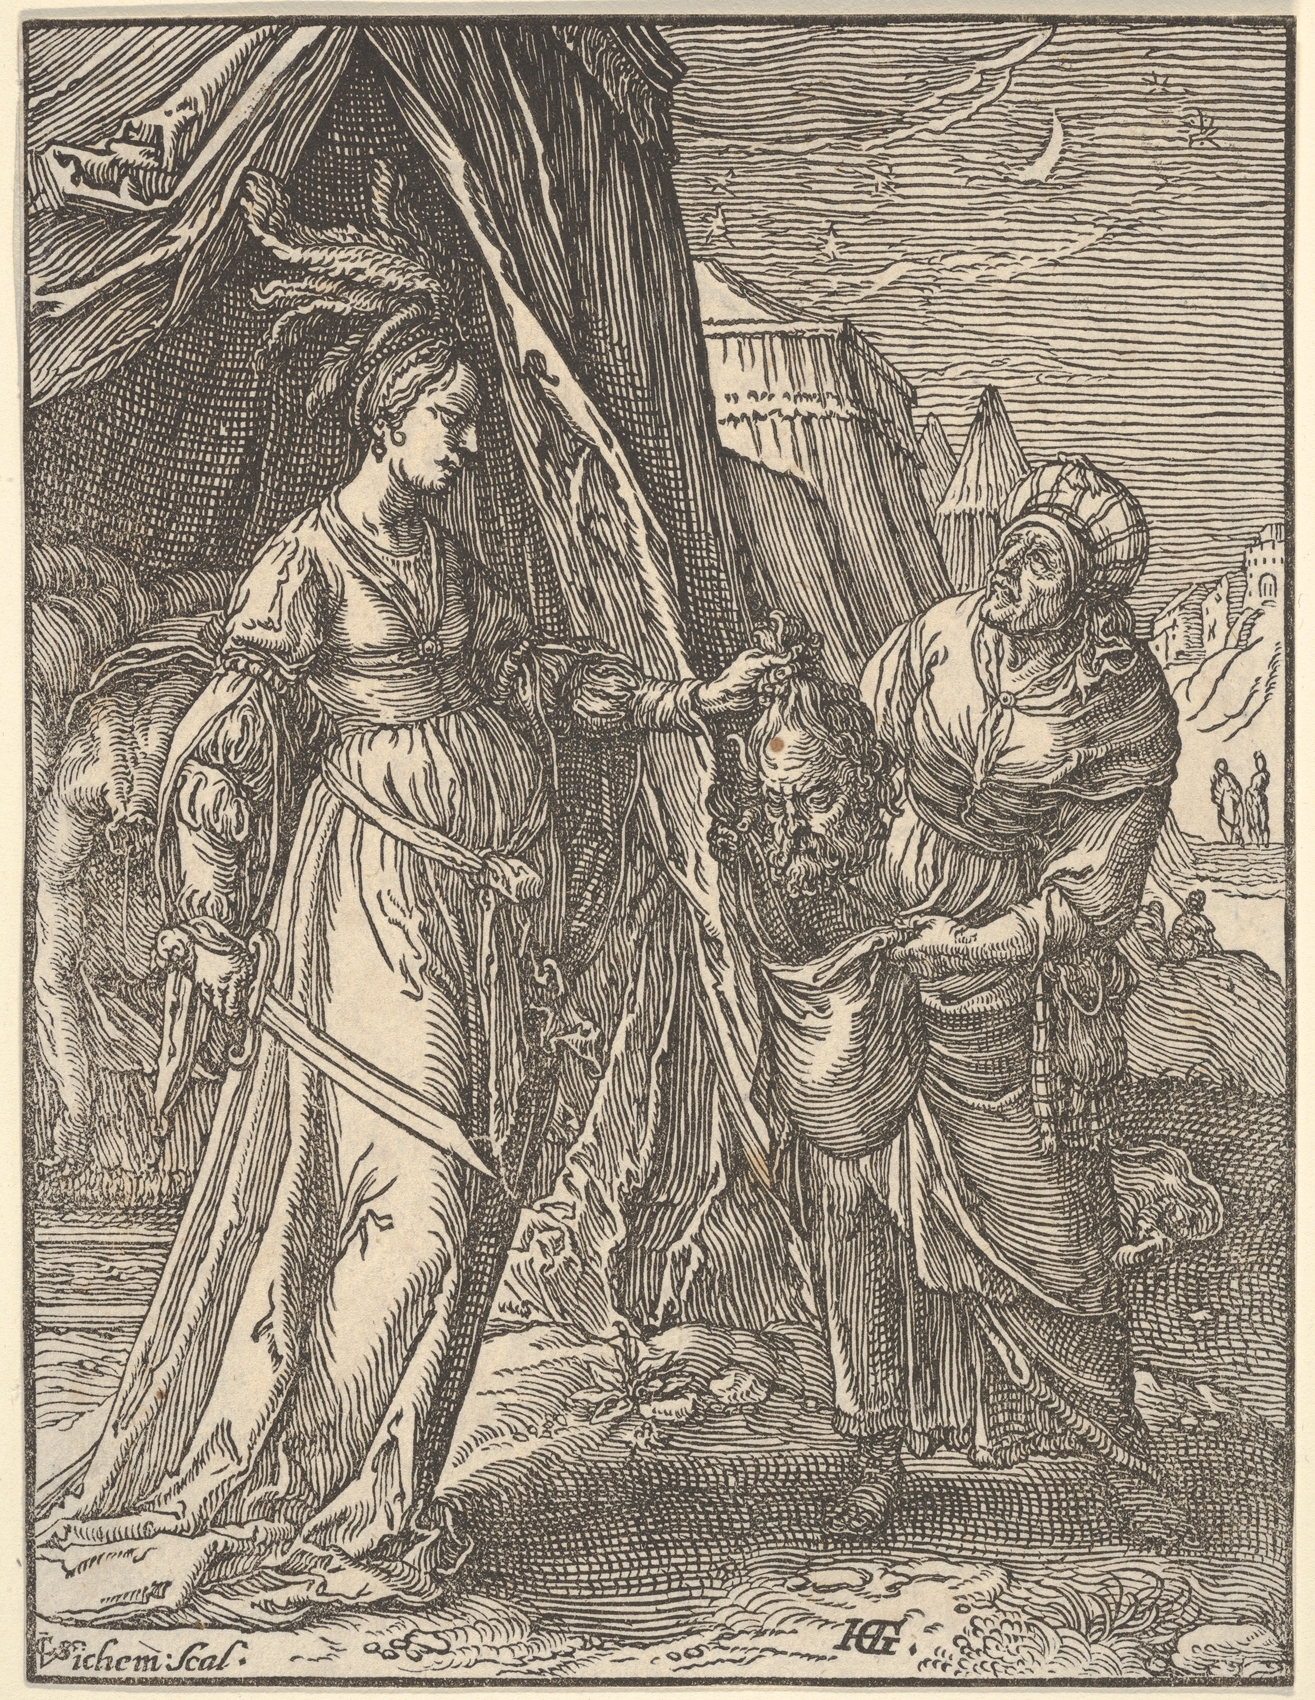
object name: print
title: Judith, after Goltzius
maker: christoffel van sichem i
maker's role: artist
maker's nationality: netherlandish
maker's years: 1546-1624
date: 1550-1624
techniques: woodcut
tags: swords,heads,holofernes,judith